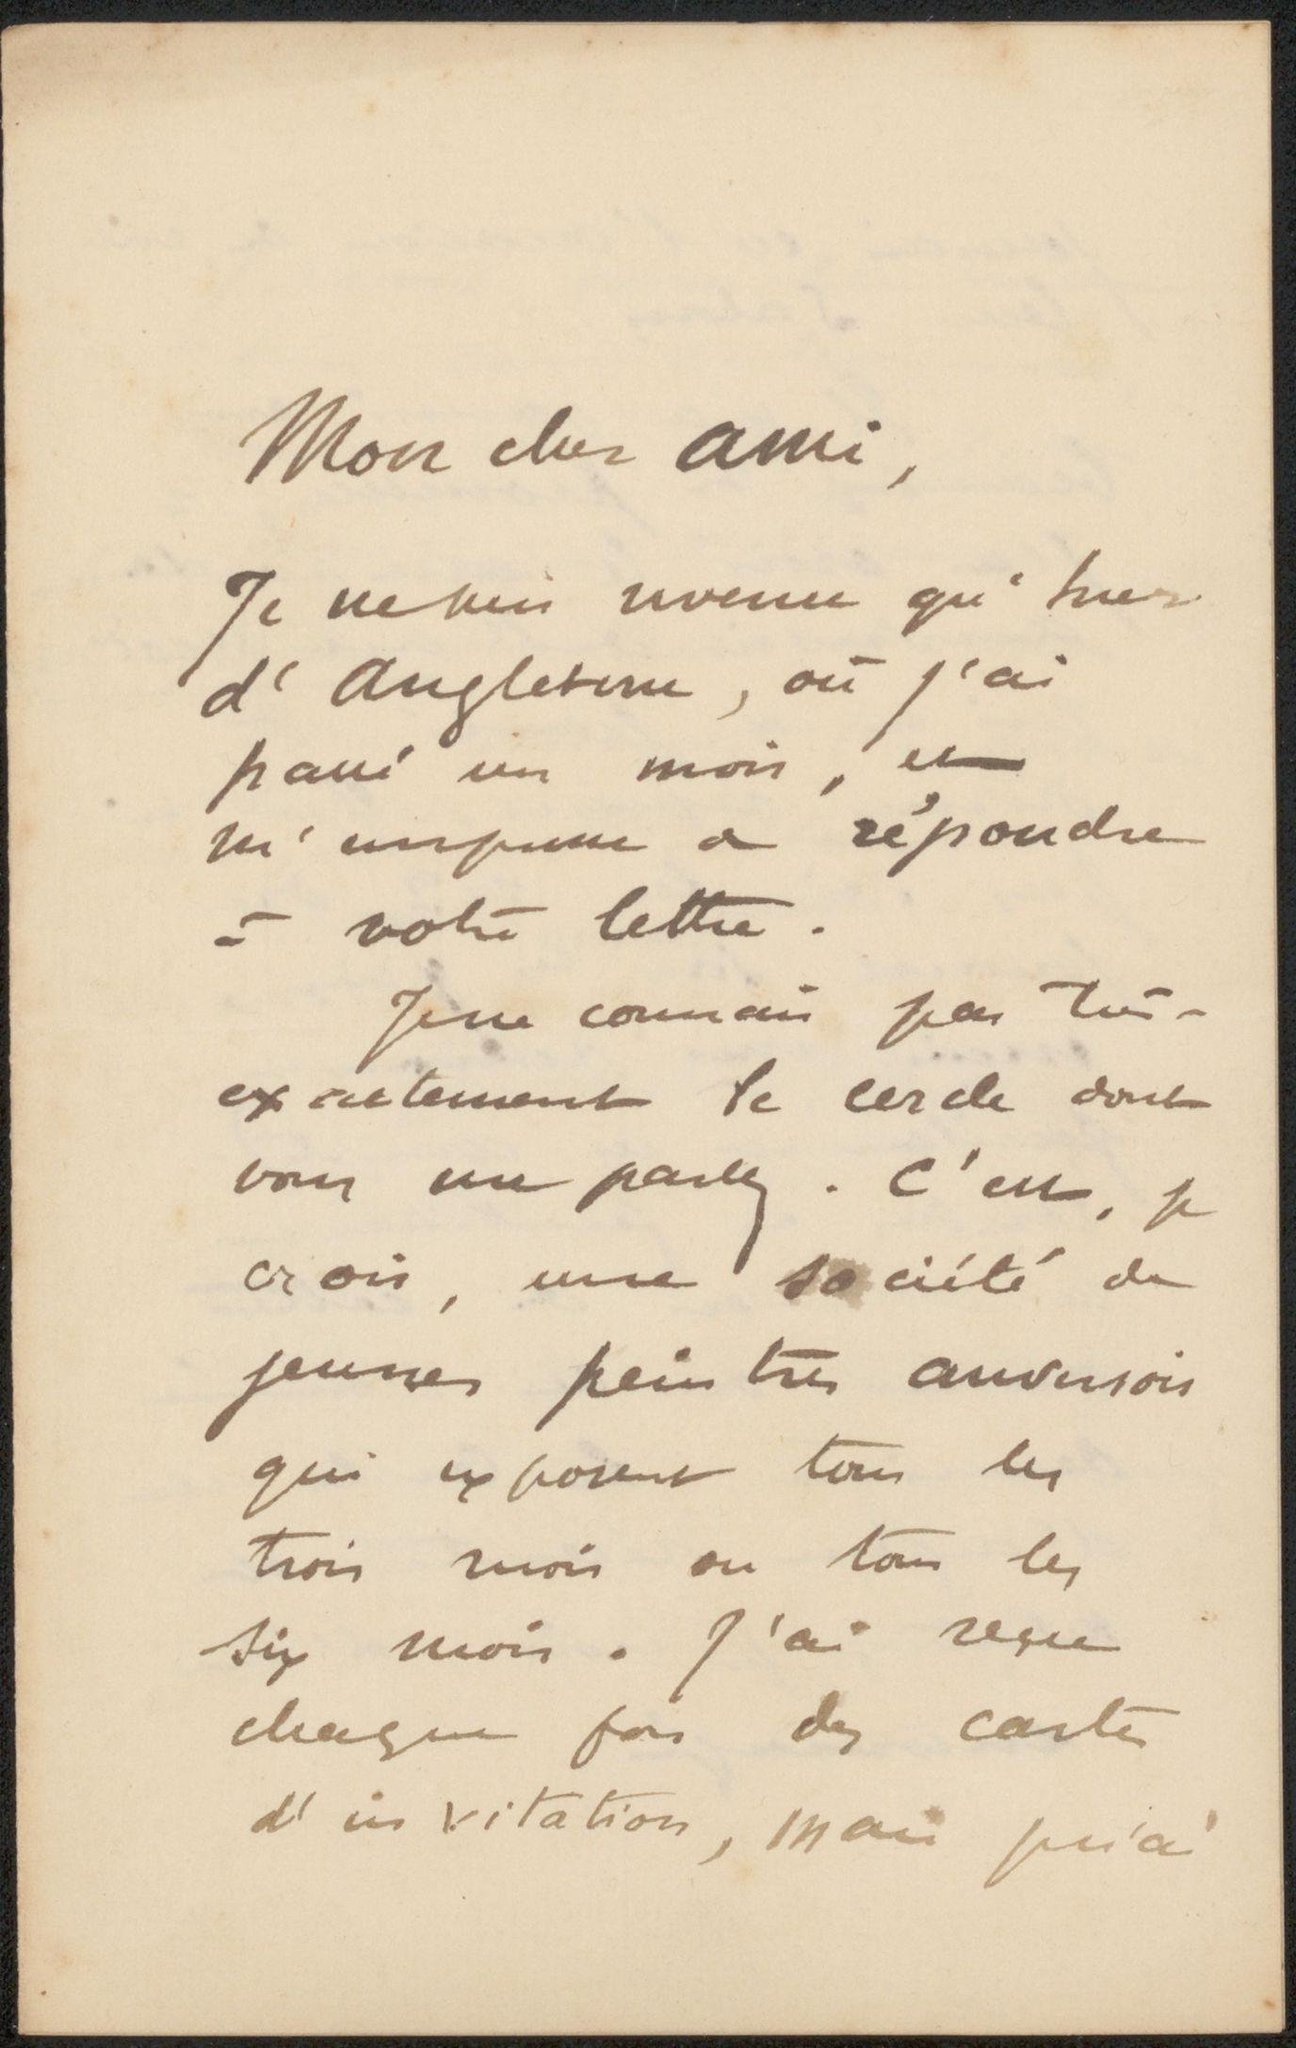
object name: letter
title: Brief aan Philip Zilcken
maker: octave maus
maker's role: painter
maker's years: 1856-1919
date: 1889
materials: ink, paper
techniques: pen, writing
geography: luxembourg city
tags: draughtsman, marinus van der maarel, philip zilcken, england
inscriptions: collector's mark: ‘RPK’